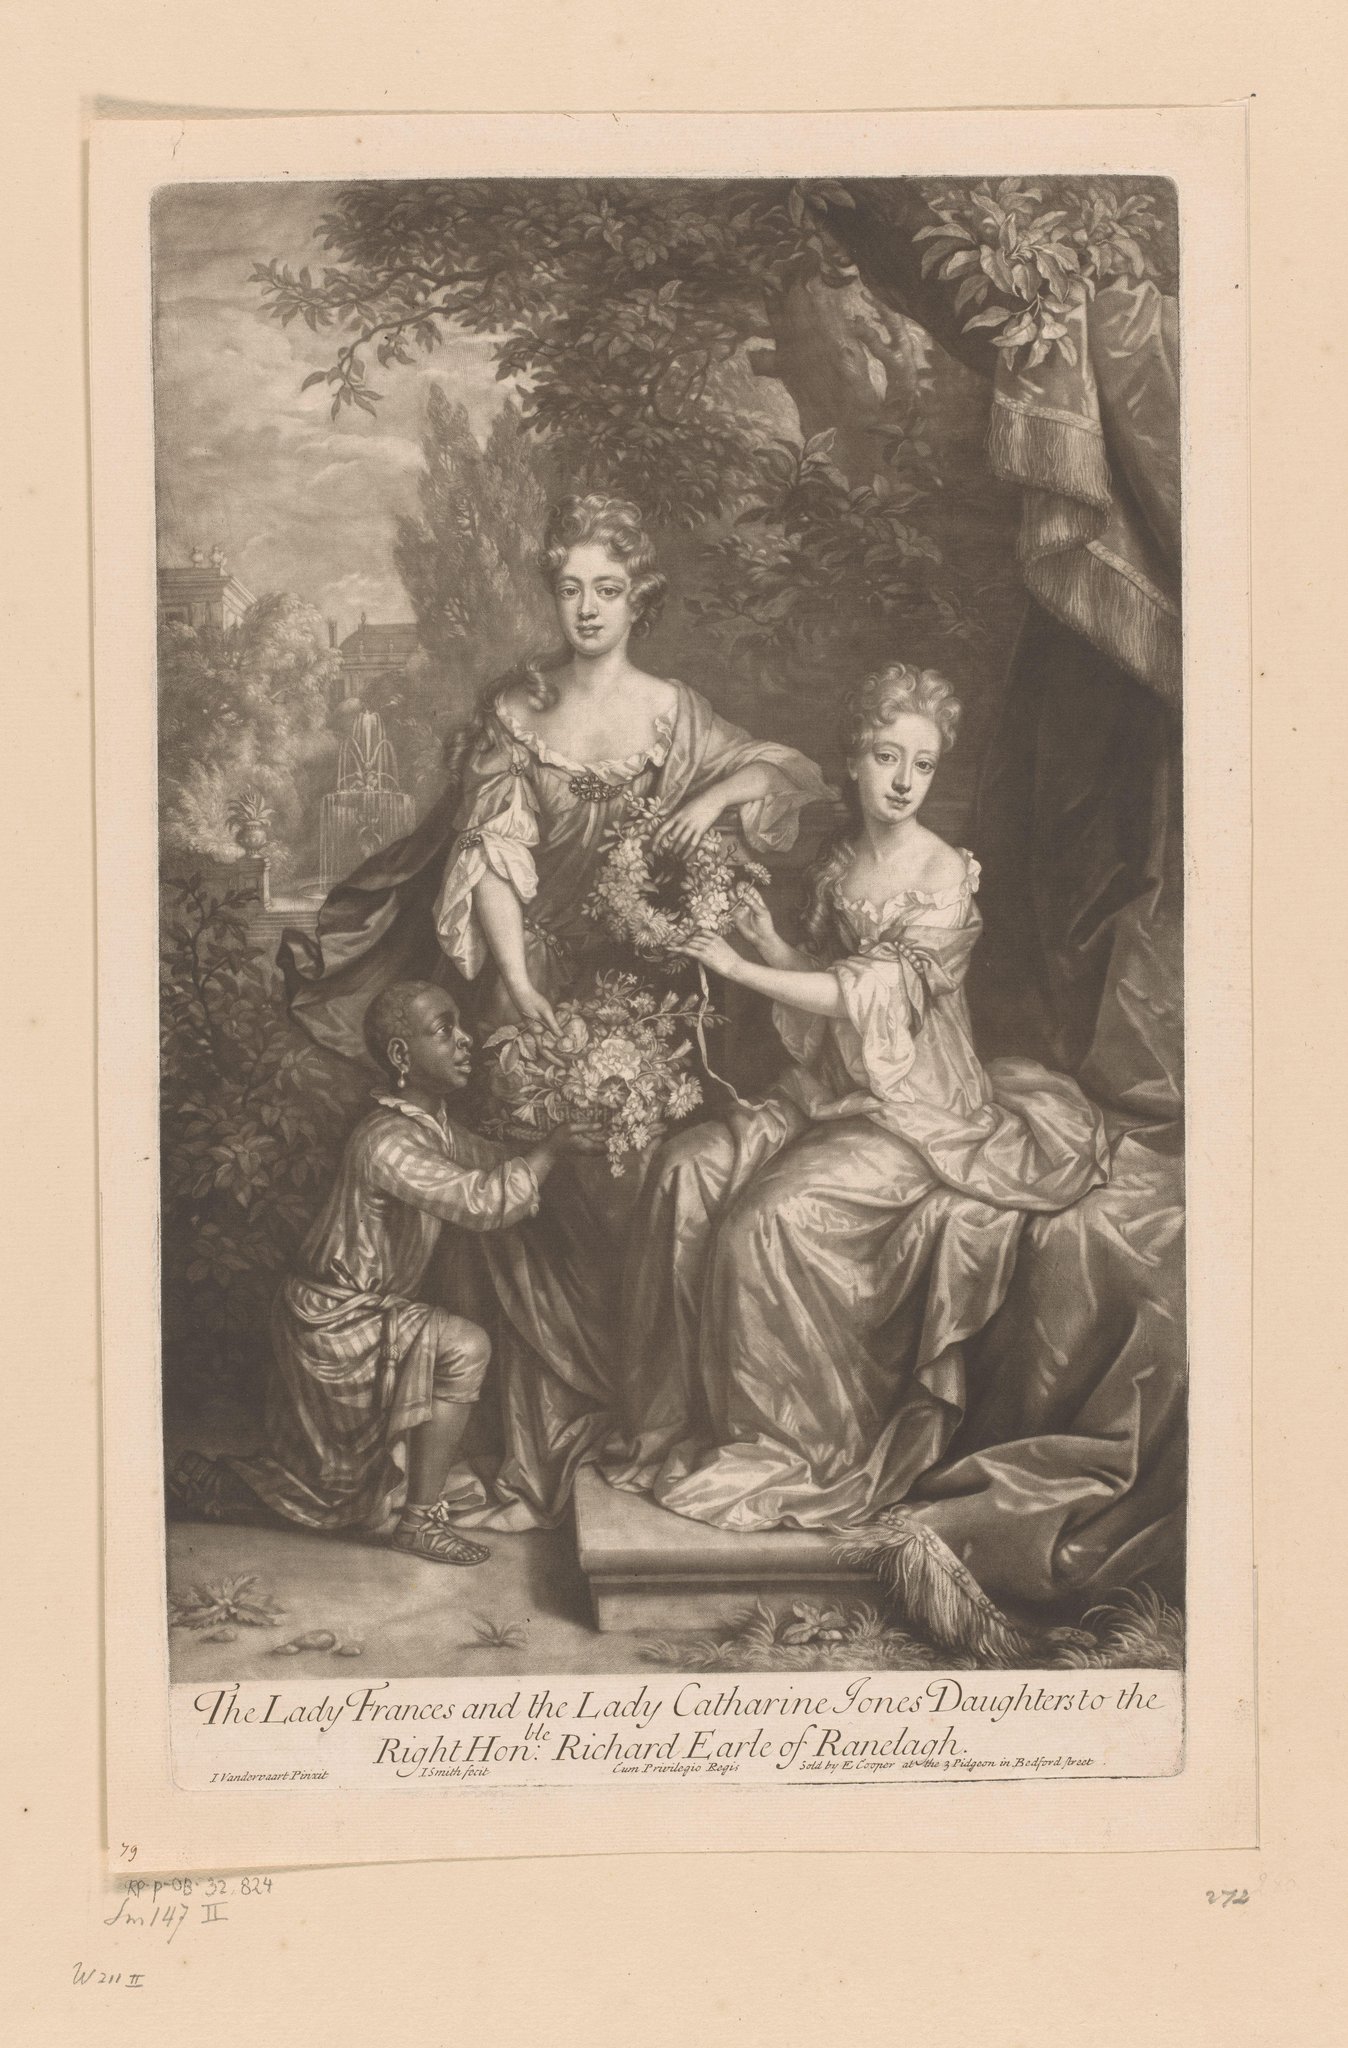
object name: print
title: The Lady Frances and the Lady Catharine Jones Daughters to the Right Honorable Richard Earle of Ranelagh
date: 1686-1725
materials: paper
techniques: mezzotint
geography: london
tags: adolescent, young woman, maiden, historical persons, page, footboy, house personnel, servants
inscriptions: collector's mark: Lugt 240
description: Mand met bloemen vastgehouden door een zwart kind, mogelijk een bediende of page. Achter de witte kinderen is een tuin, fontein en een villa zichtbaar.